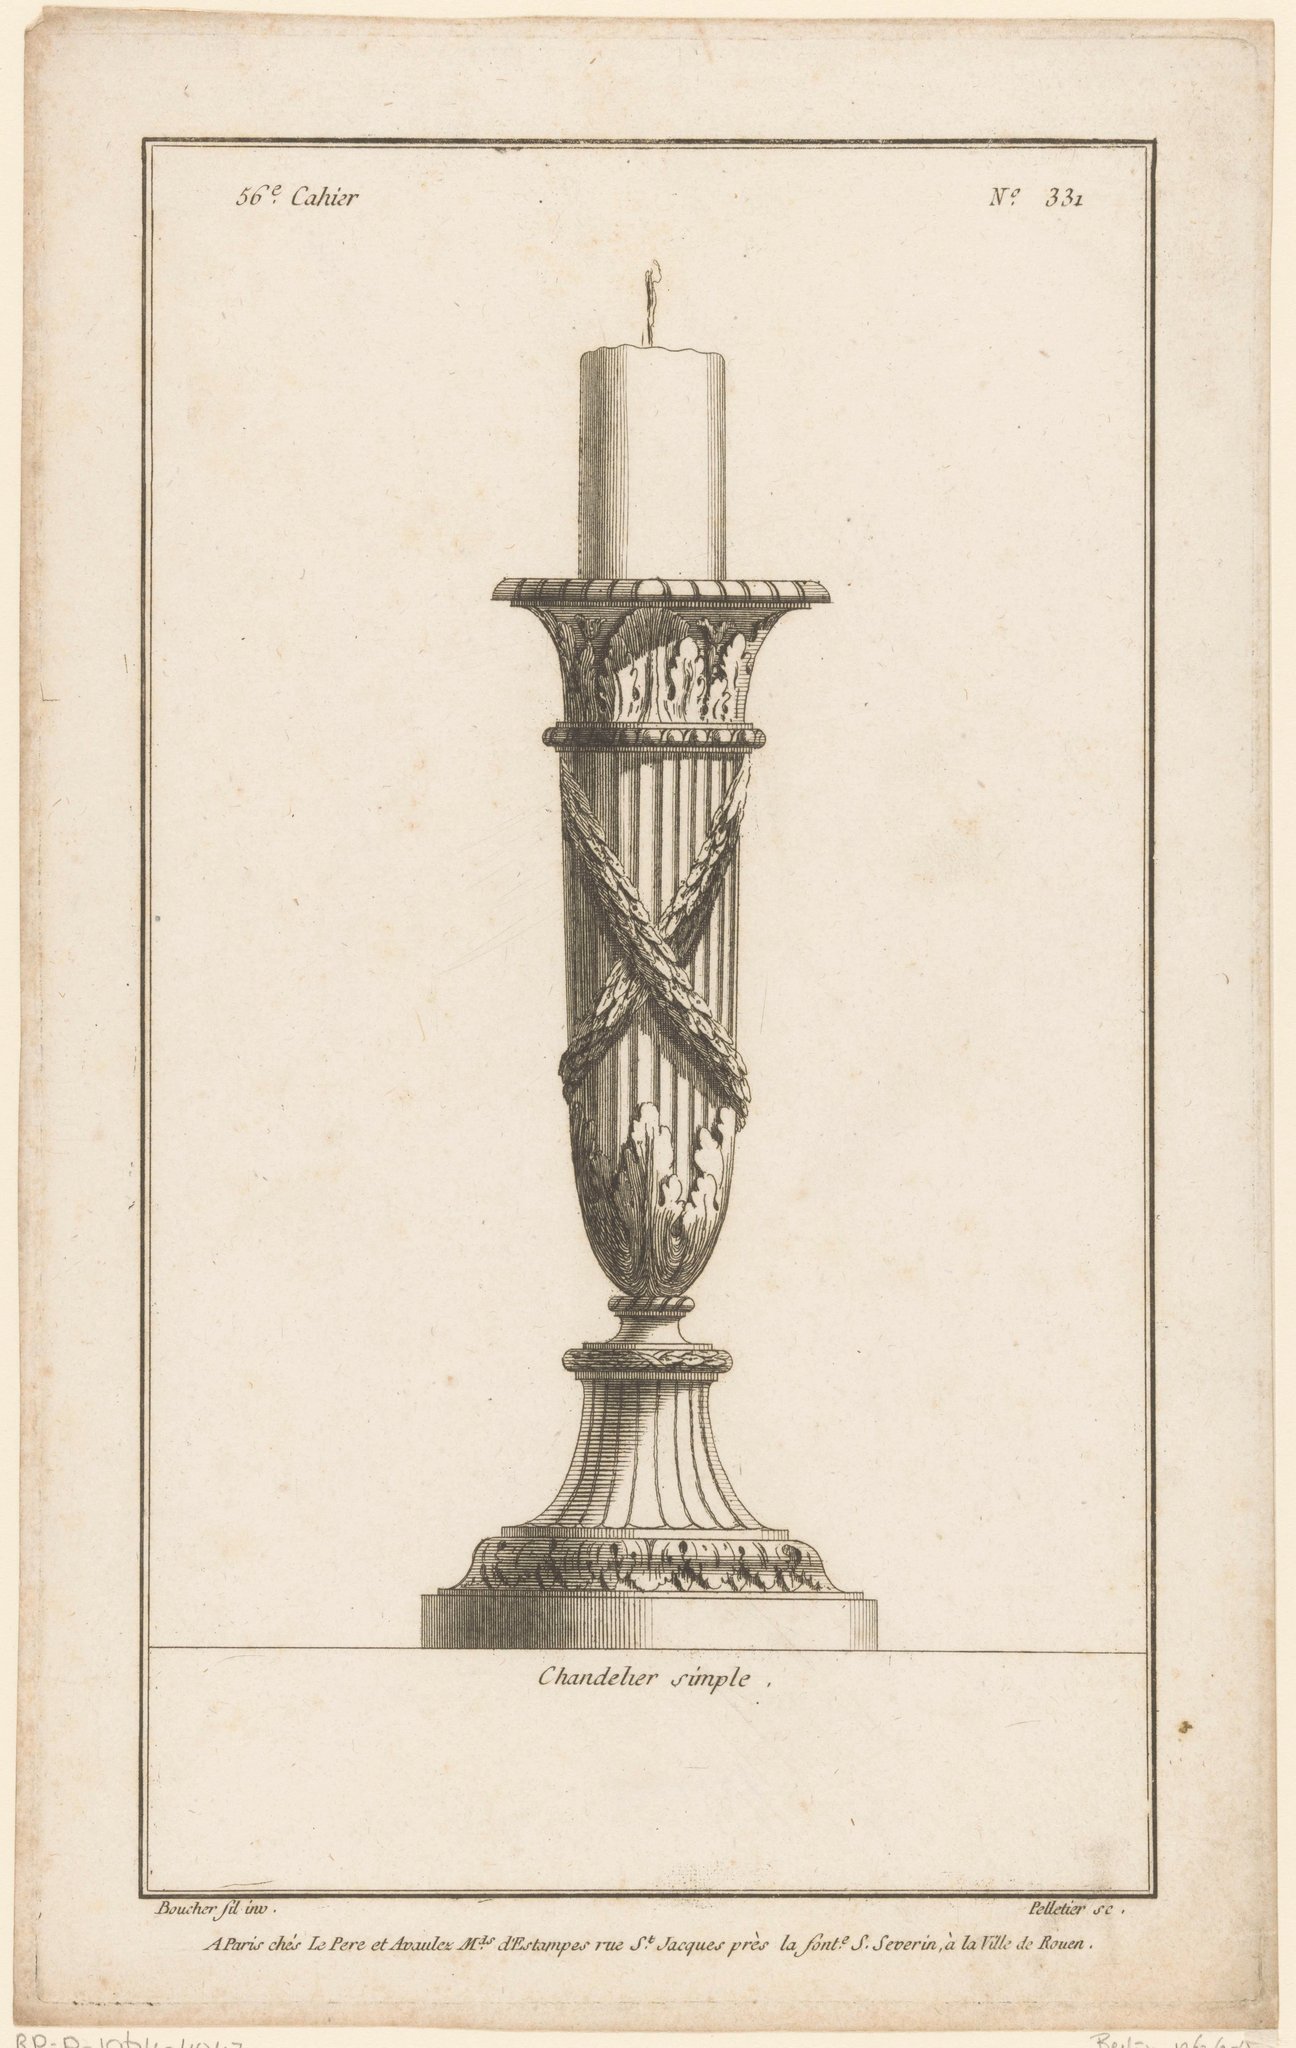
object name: ornament print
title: Kandelaars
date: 1772-1779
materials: paper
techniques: engraving, etching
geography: paris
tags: foliage ~ ornament, chandelier, candelabrum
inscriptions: collector's mark: Lugt 2228, collector's mark: Lugt 2760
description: Een geornamenteerde kandelaar met bladmotieven. Prentnummer 331.